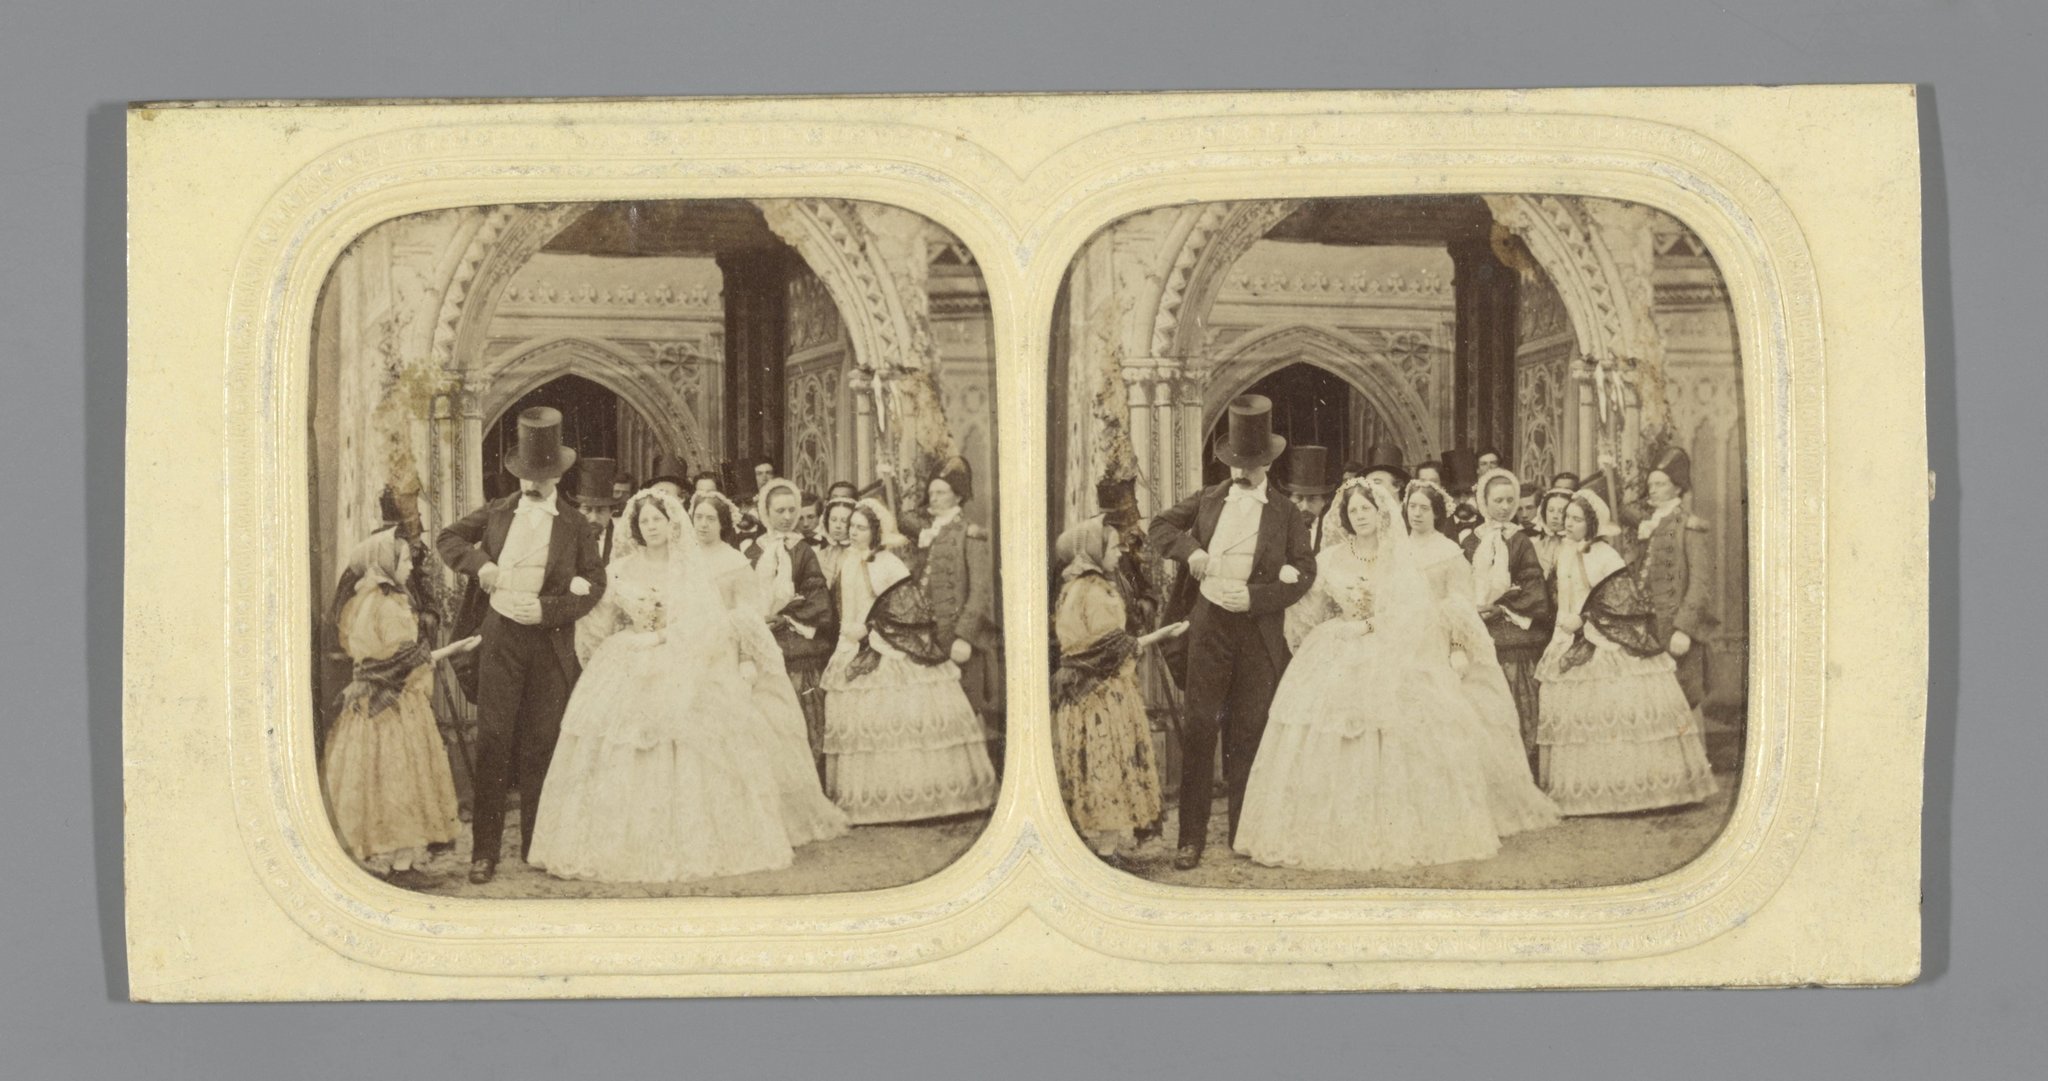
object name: tissue stereograph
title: Bruidspaar verlaat kerk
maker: Anonymous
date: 1855-1875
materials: cardboard, paper, photographic support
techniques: albumen print, hand coloring, perforating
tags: married couple leaving the church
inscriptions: inscription: ‘CG zp + f1.-’